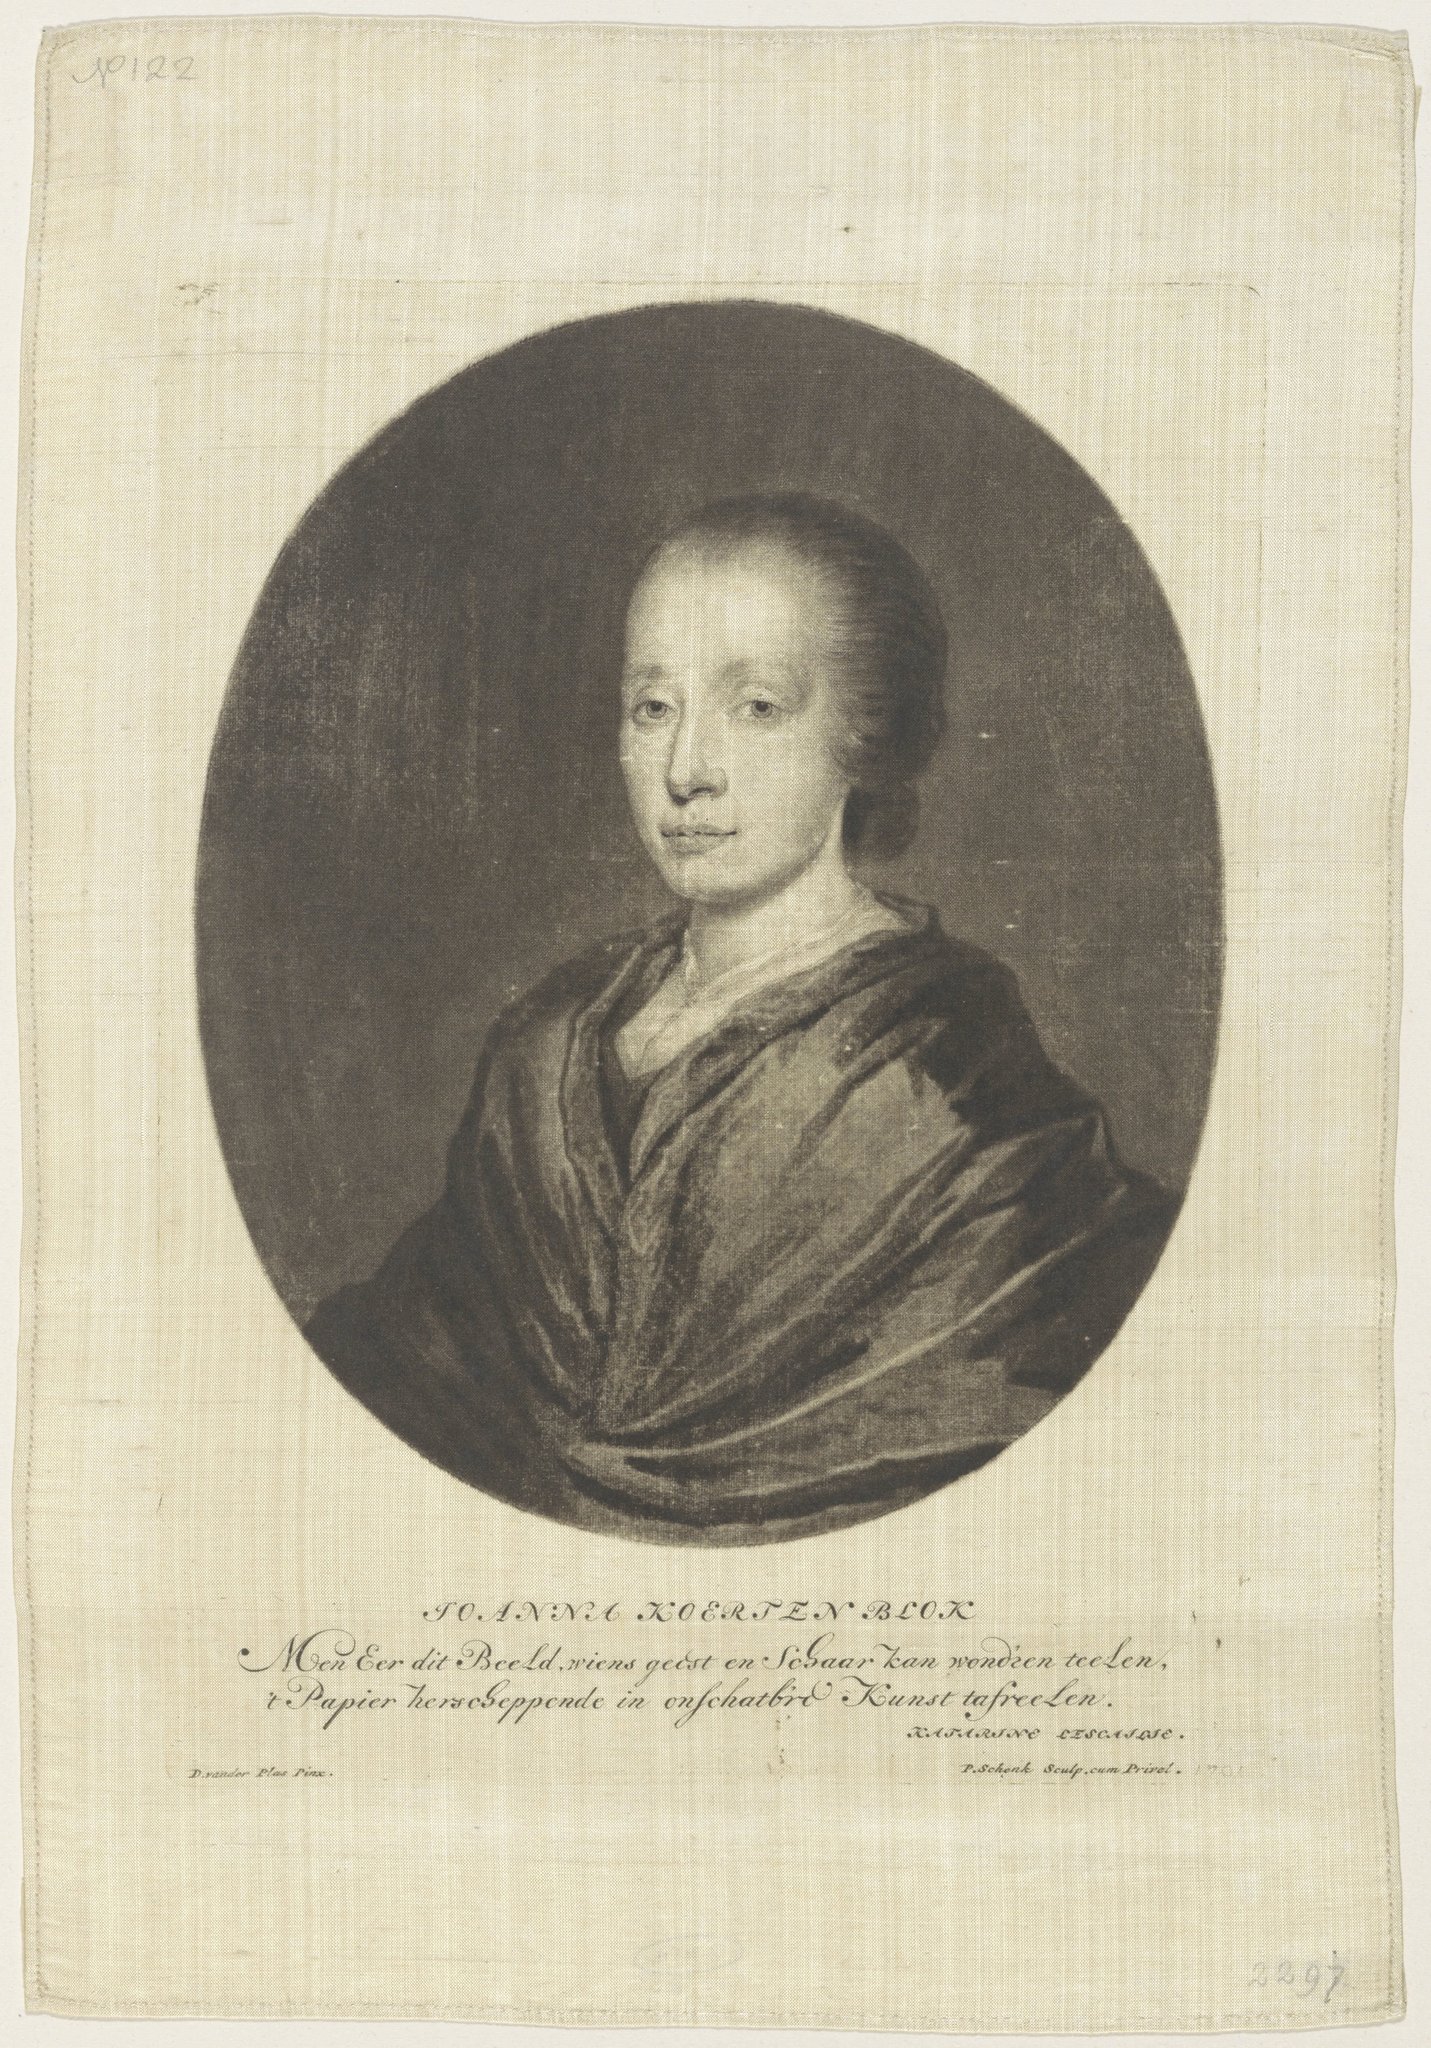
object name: print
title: Portret van de knipkunstenares Johanna Koerten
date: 1701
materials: silk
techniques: engraving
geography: amsterdam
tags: draughtsman, johanna koerten, portrait, self-portrait of artist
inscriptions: collector's mark: Lugt 2228